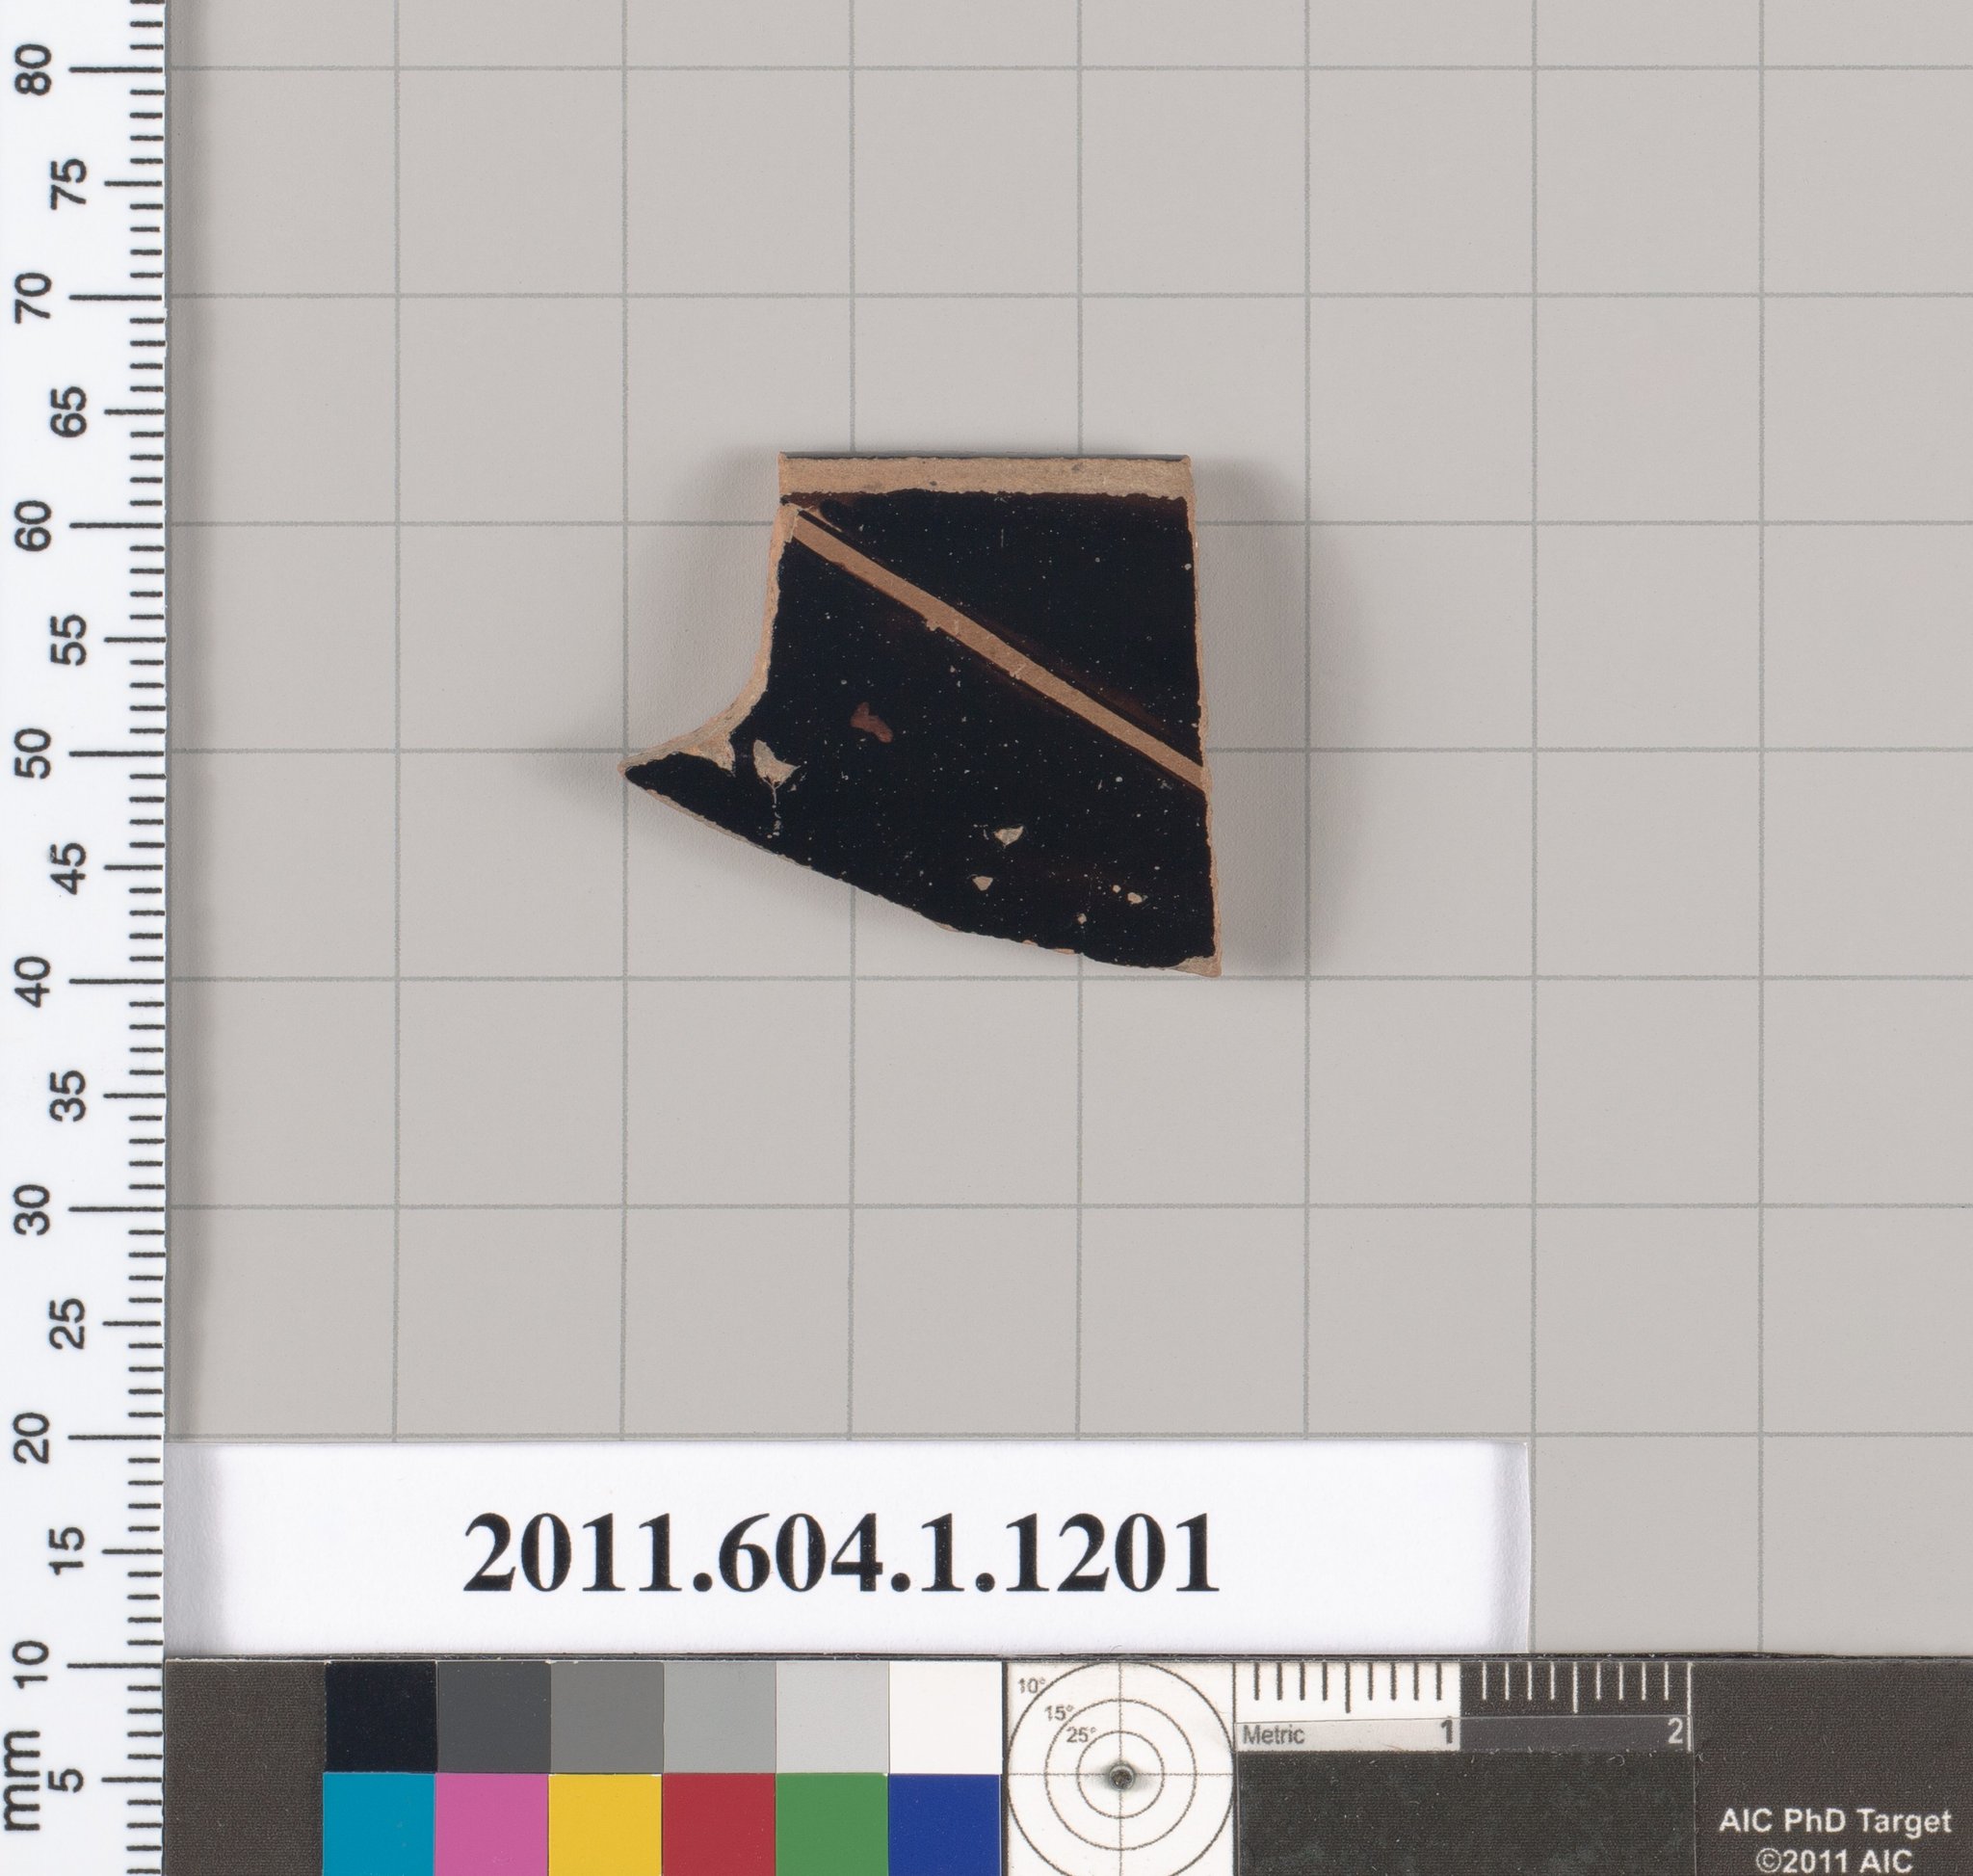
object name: kylix fragment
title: Terracotta rim fragment of a kylix (drinking cup)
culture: greek, attic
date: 490-480 BCE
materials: terracotta